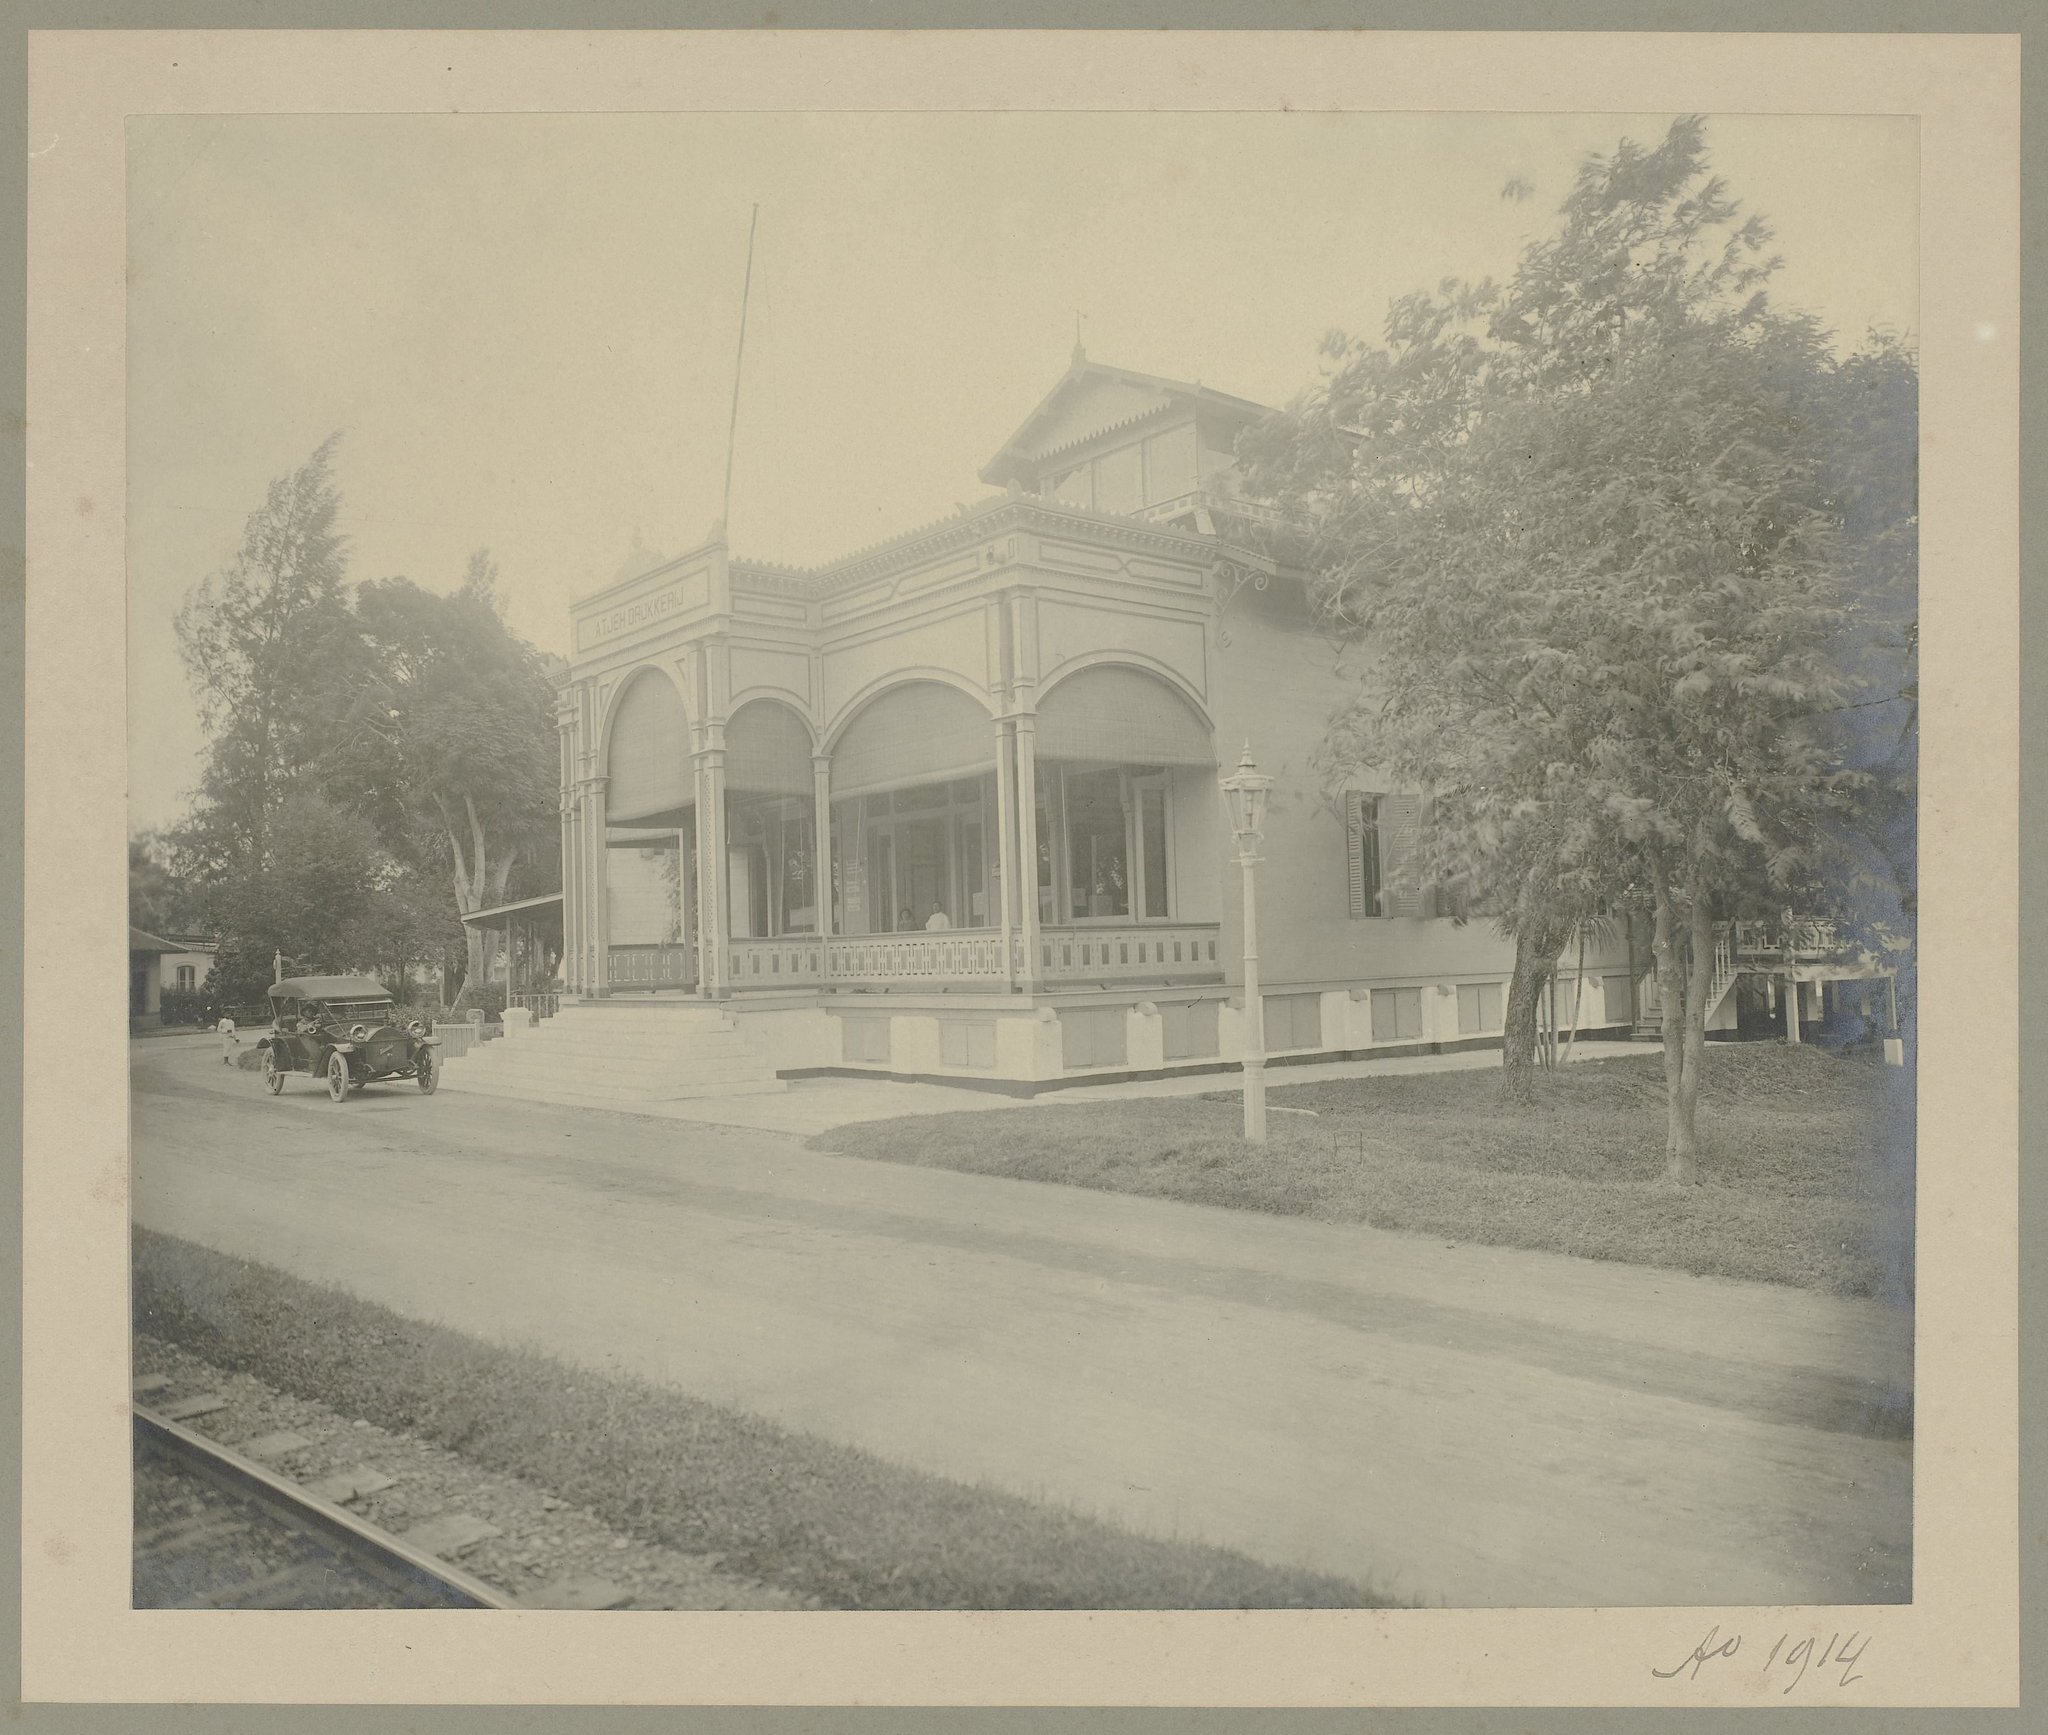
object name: photograph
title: Atjeh Drukkerij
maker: Anonymous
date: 1914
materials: cardboard, photographic support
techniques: gelatin silver print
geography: banda atjeh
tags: dutch east indies, the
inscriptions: inscription: ‘Ao 1914’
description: Gezicht op de Atjeh drukkerij te Banda Atjeh, 1914. Langs de weg bij de trap staat een auto geparkeerd. Foto opgeplakt op karton. Onderdeel van een groep van negen foto's over de Atjeh-drukkerij.